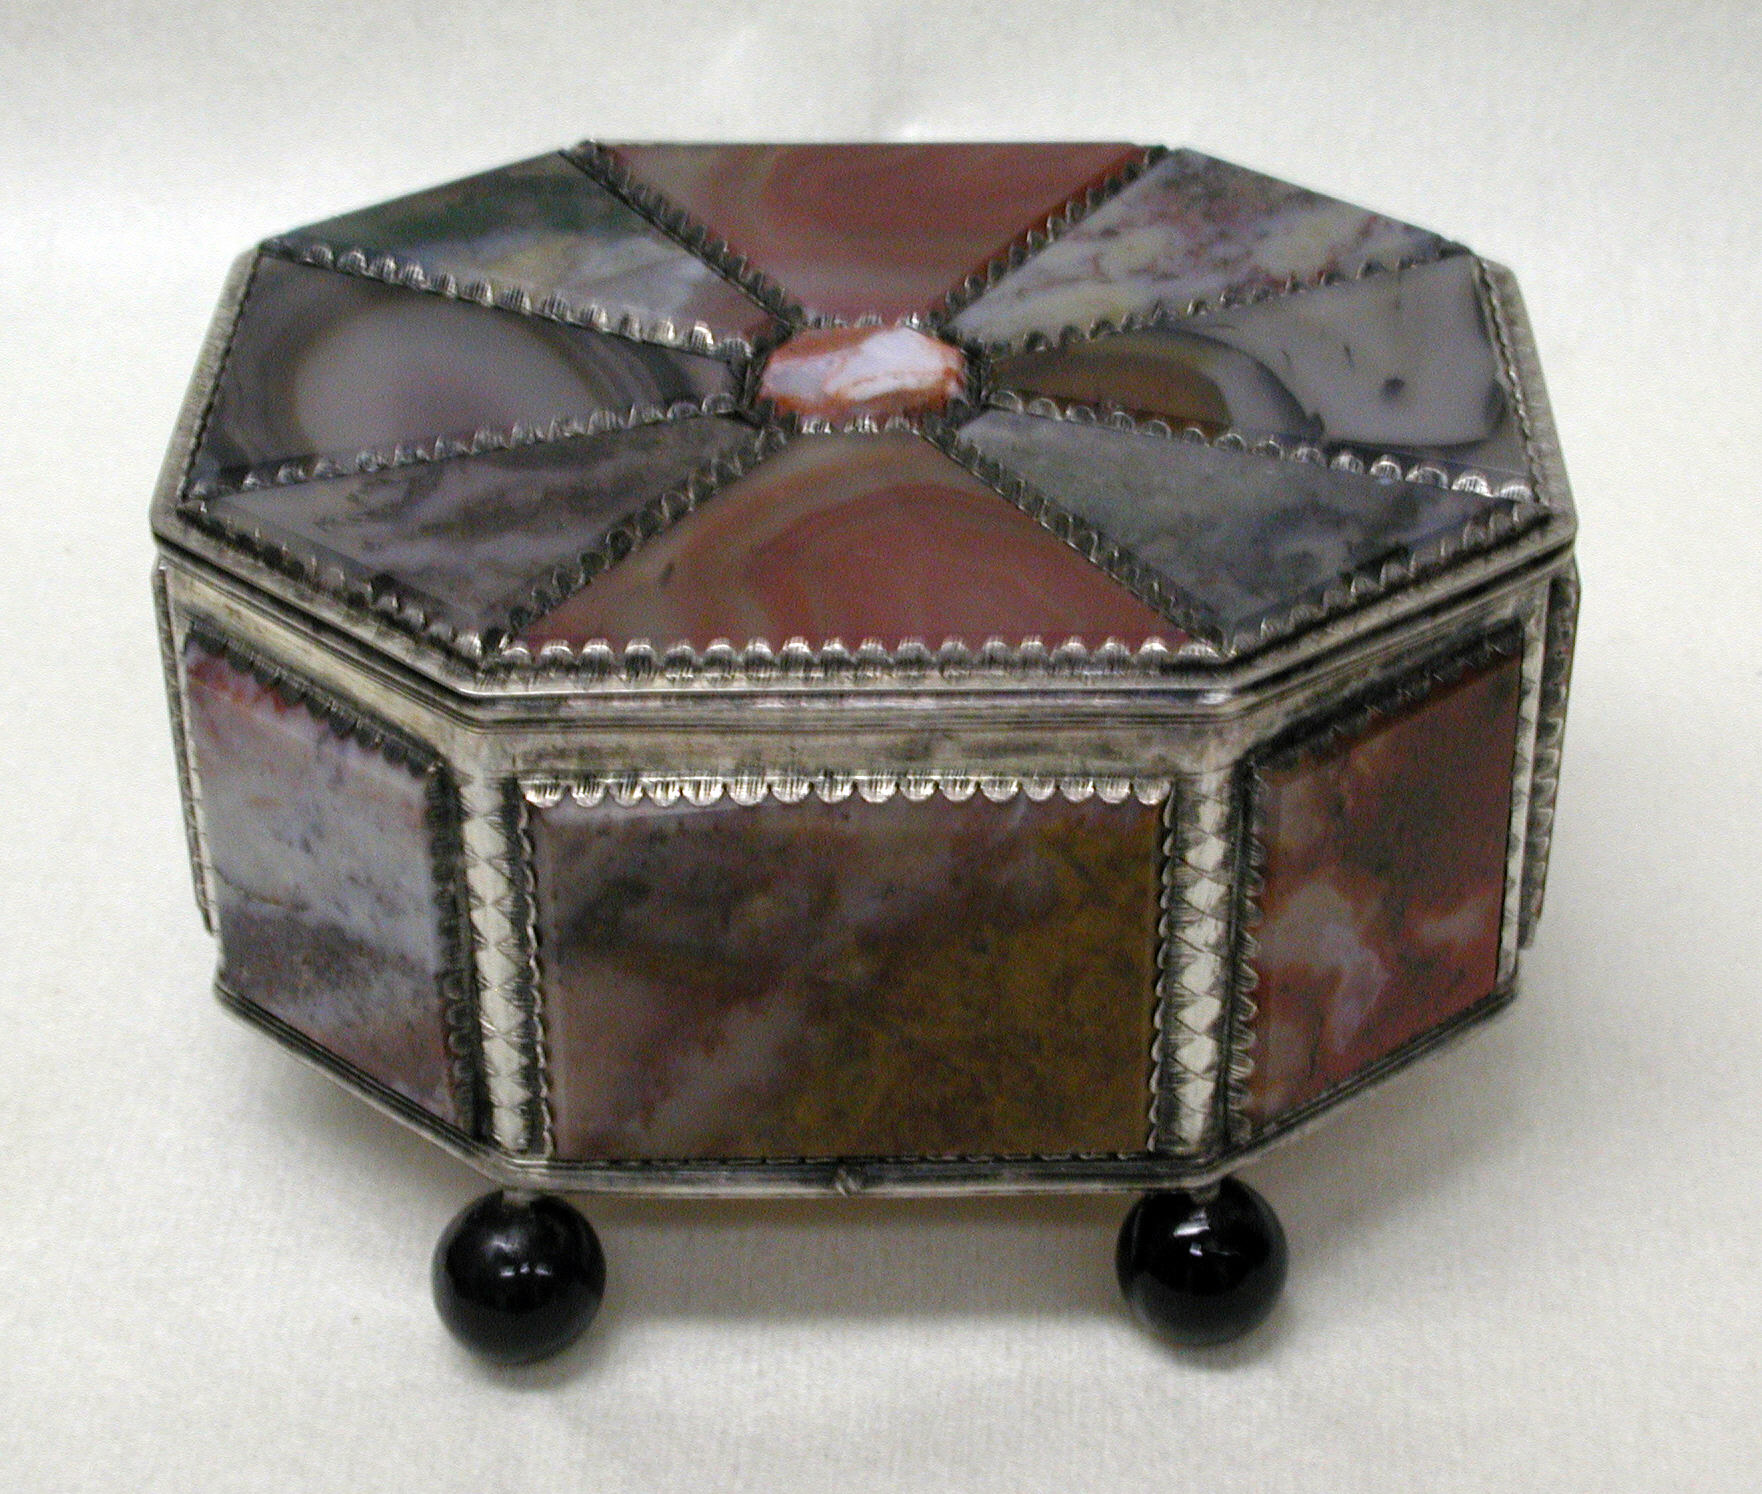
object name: box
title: Box (part of a set)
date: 1675-1700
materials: stone, onyx, silver